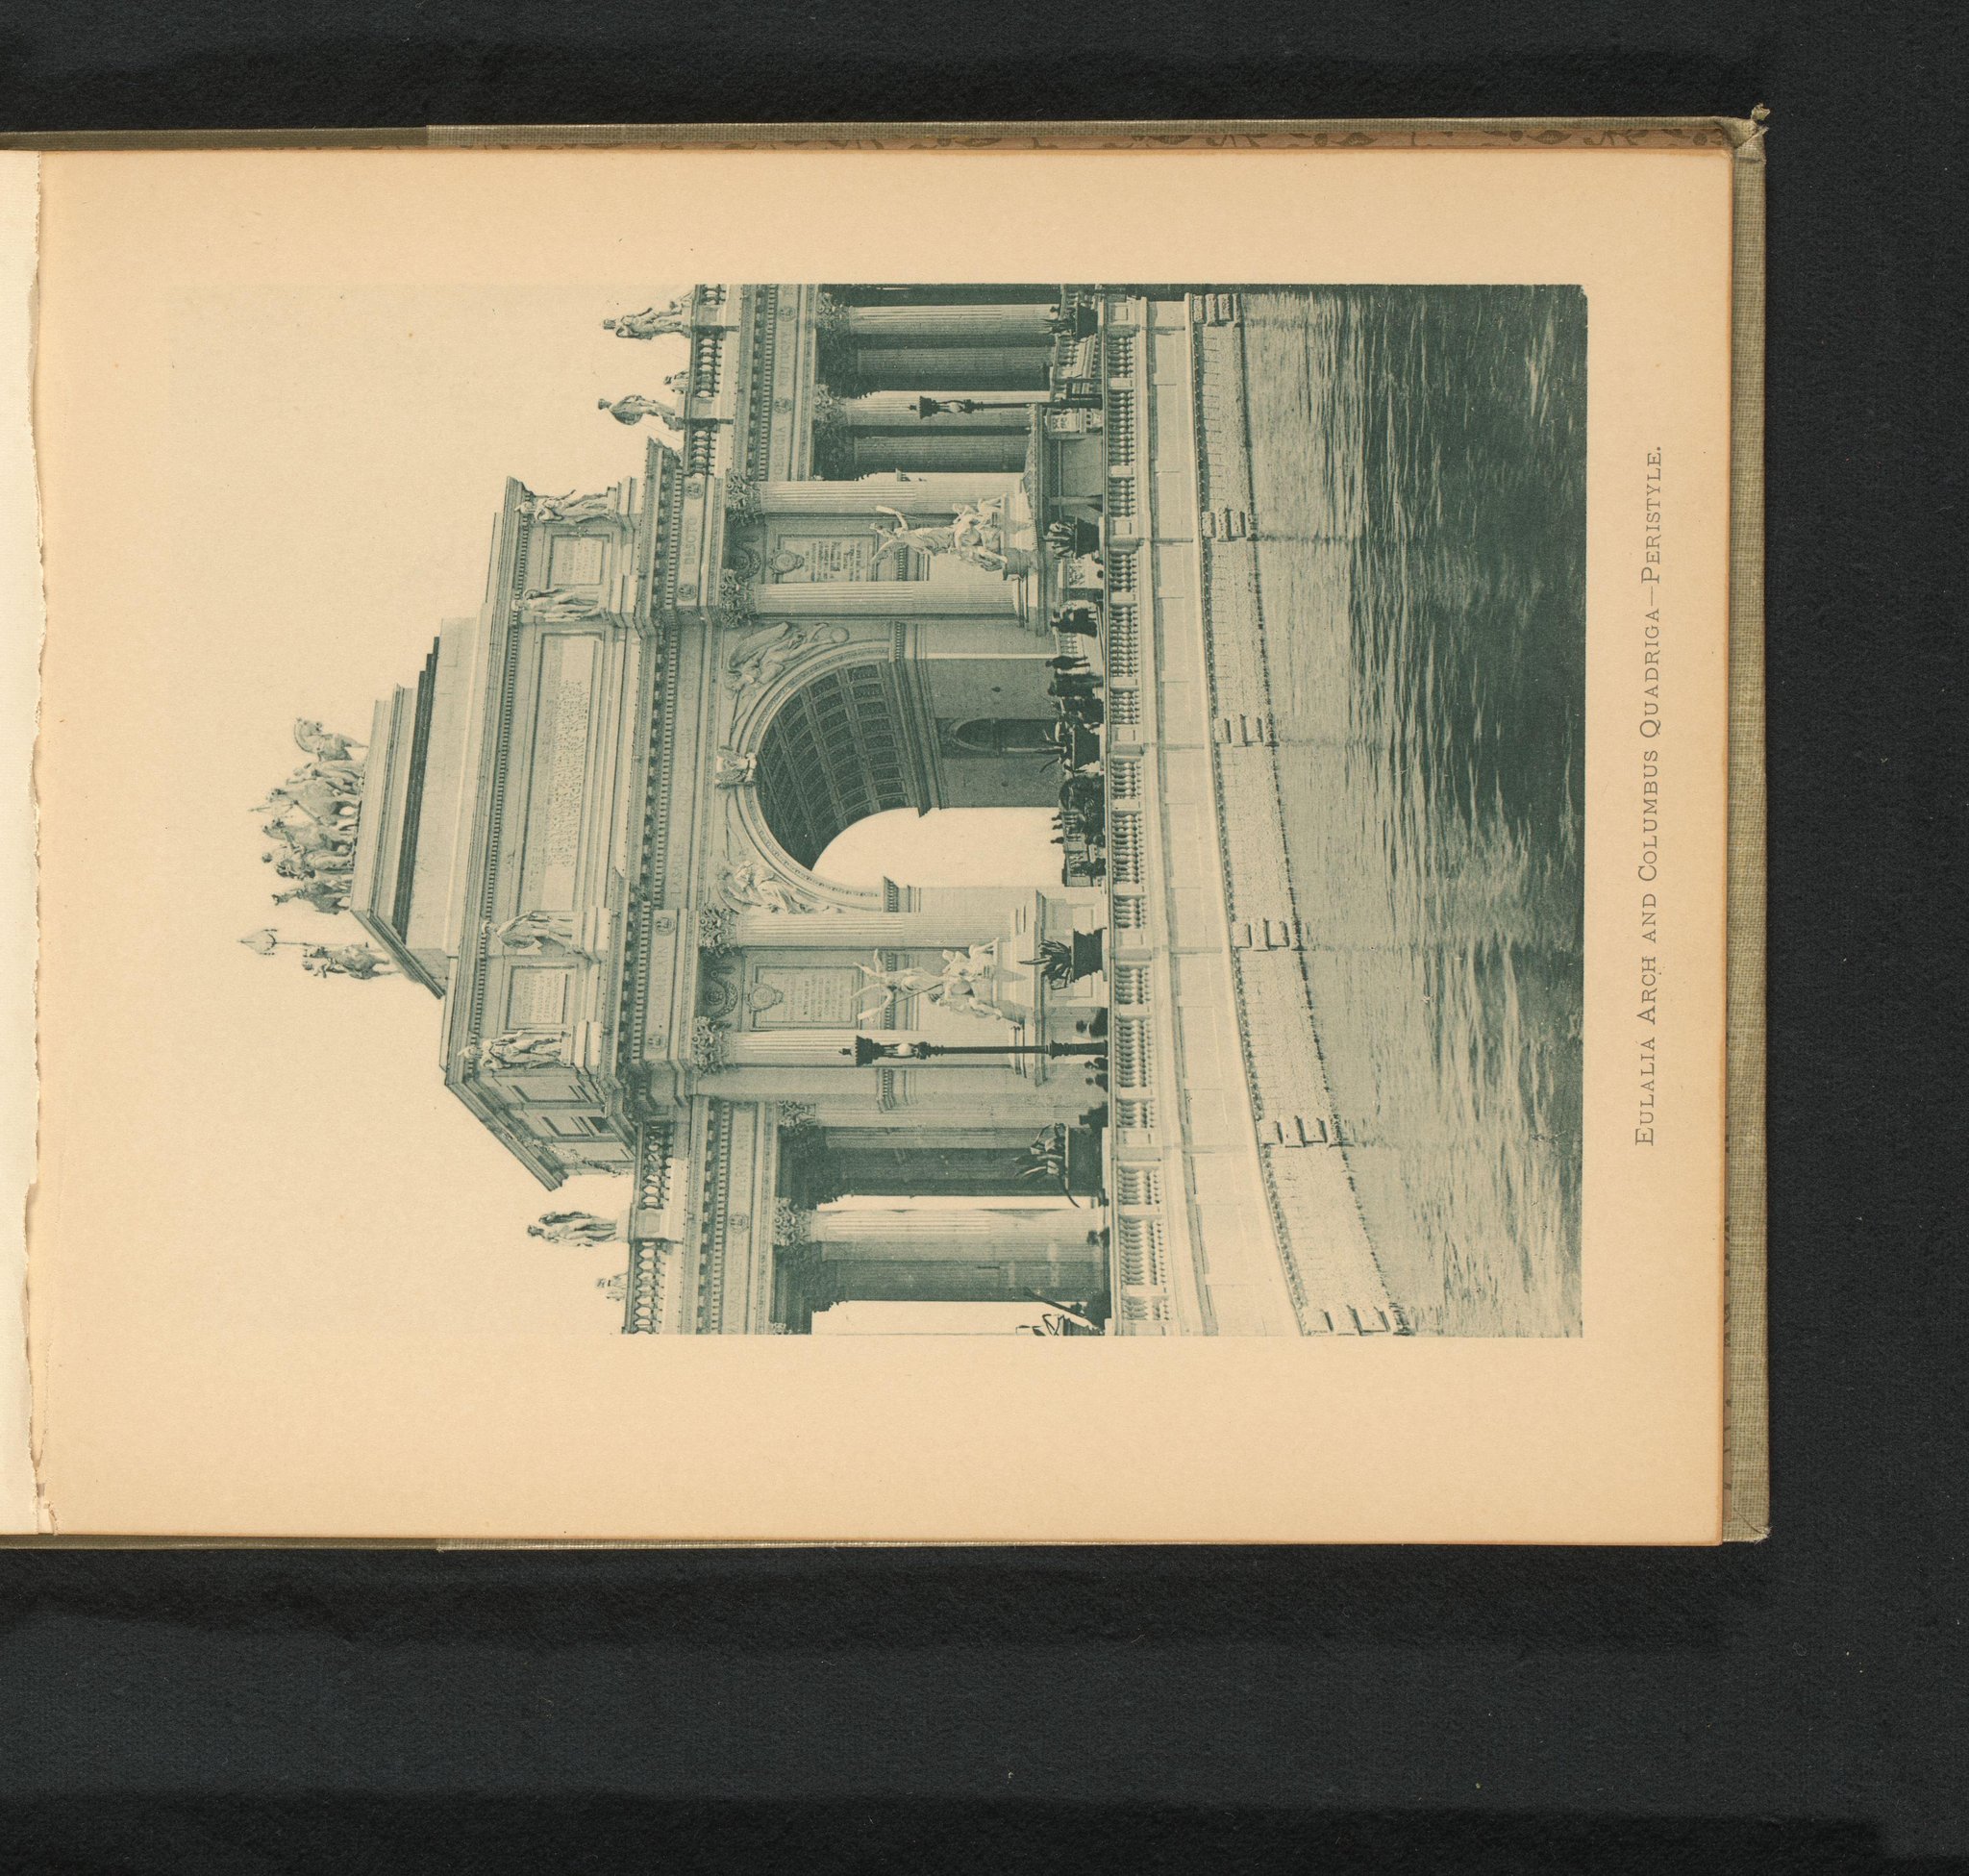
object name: photomechanical print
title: Gezicht op de toegangsboog met zuilengalerij van de World's Columbian Exposition in Chicago in 1893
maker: Anonymous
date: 1893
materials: paper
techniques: photograph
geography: chicago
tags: colonnade, world fair, world exhibition, arch, archivolt ~ architecture, quadriga